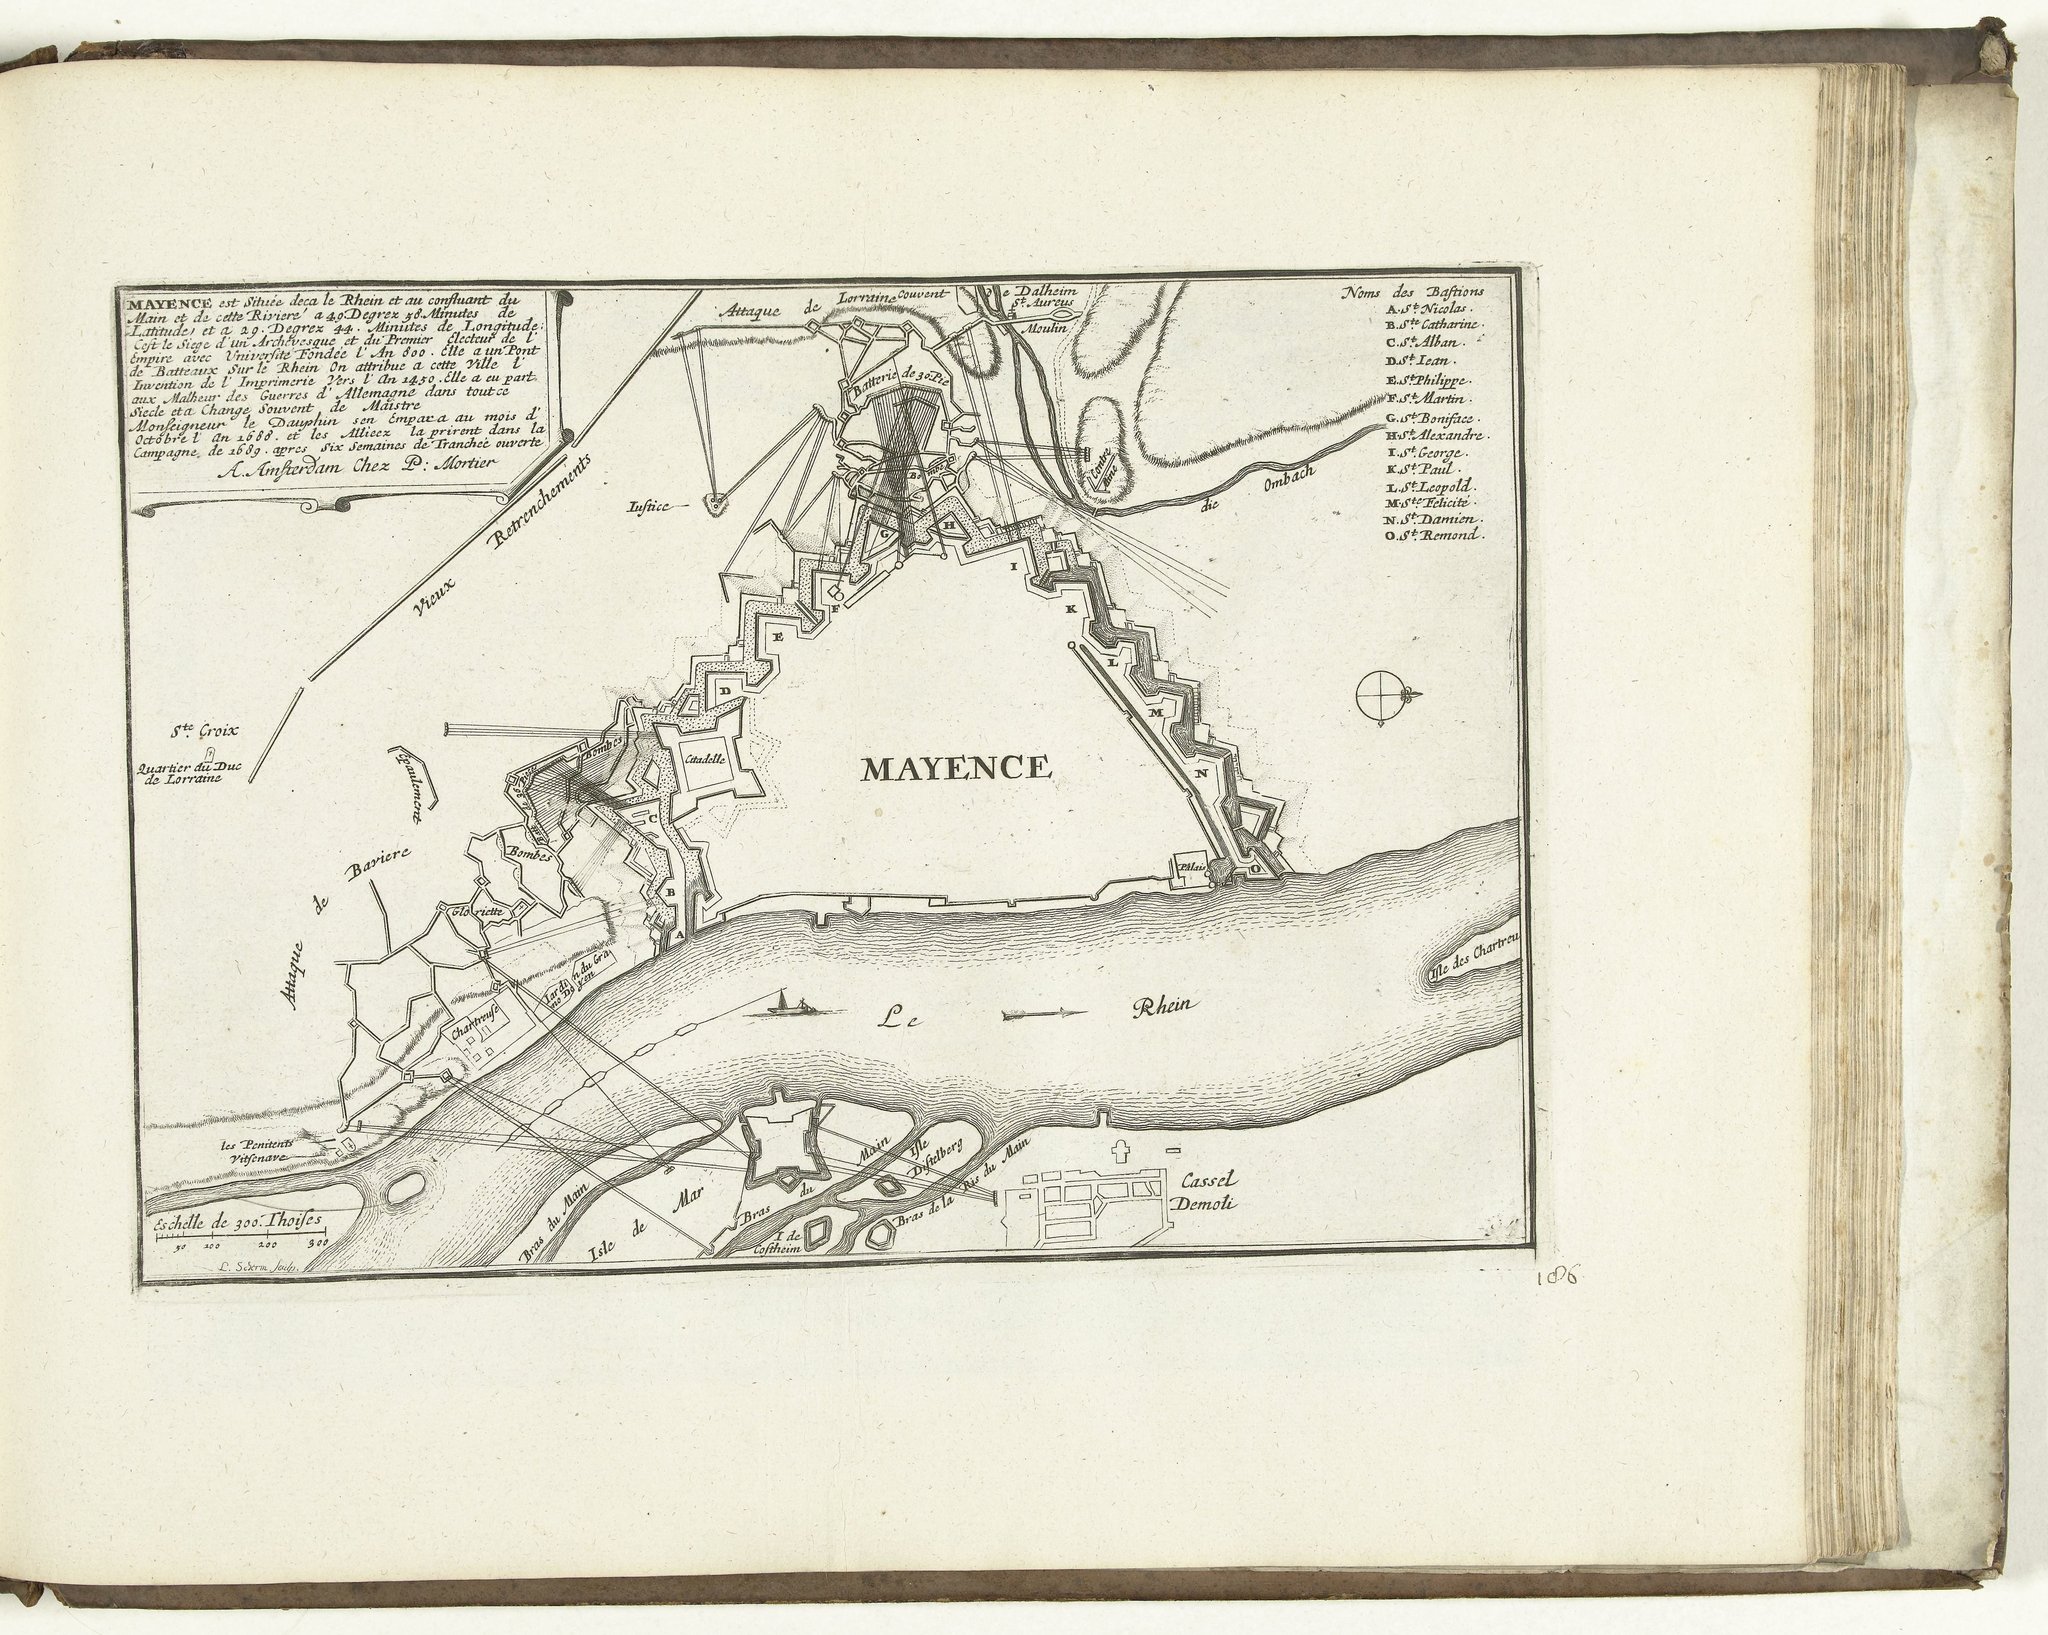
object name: print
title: Les Forces de l'Europe, Asie, Afrique et Amerique (...) Comme aussi les Cartes des Côtes de France et d'Espagne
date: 1726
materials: paper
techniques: etching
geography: leiden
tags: fortress, maps of cities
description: Plattegrond van de versterkingen om de stad Mainz. Plaat nr. 186 in deel VIII van het prentwerk: Les Forces de l'Europe, Asie, Afrique et Amerique ... Comme aussi les Cartes des Côtes de France et d'Espagne uit 1726, dit eerste deel met 238 met de hand genummerde platen van vermaarde sterke steden en vestingen in het kader van de Spaanse Successieoorlog 1701-1713. Voor het merendeel zijn deze platen gekopieerd naar de anonieme Franse platen van vermaarde sterke steden en vestingen: in Les forces de l'Europe en in: Le theatre de la guerre, dans les Pays-Bas, beide oorspronkelijk uitgegeven door Nicolas de Fer te Parijs (1693-1697) in het kader van de Negenjarige Oorlog. Titel en opschriften in het Frans. Rechtsonder sporen van het weggepolijste nummer: 94.